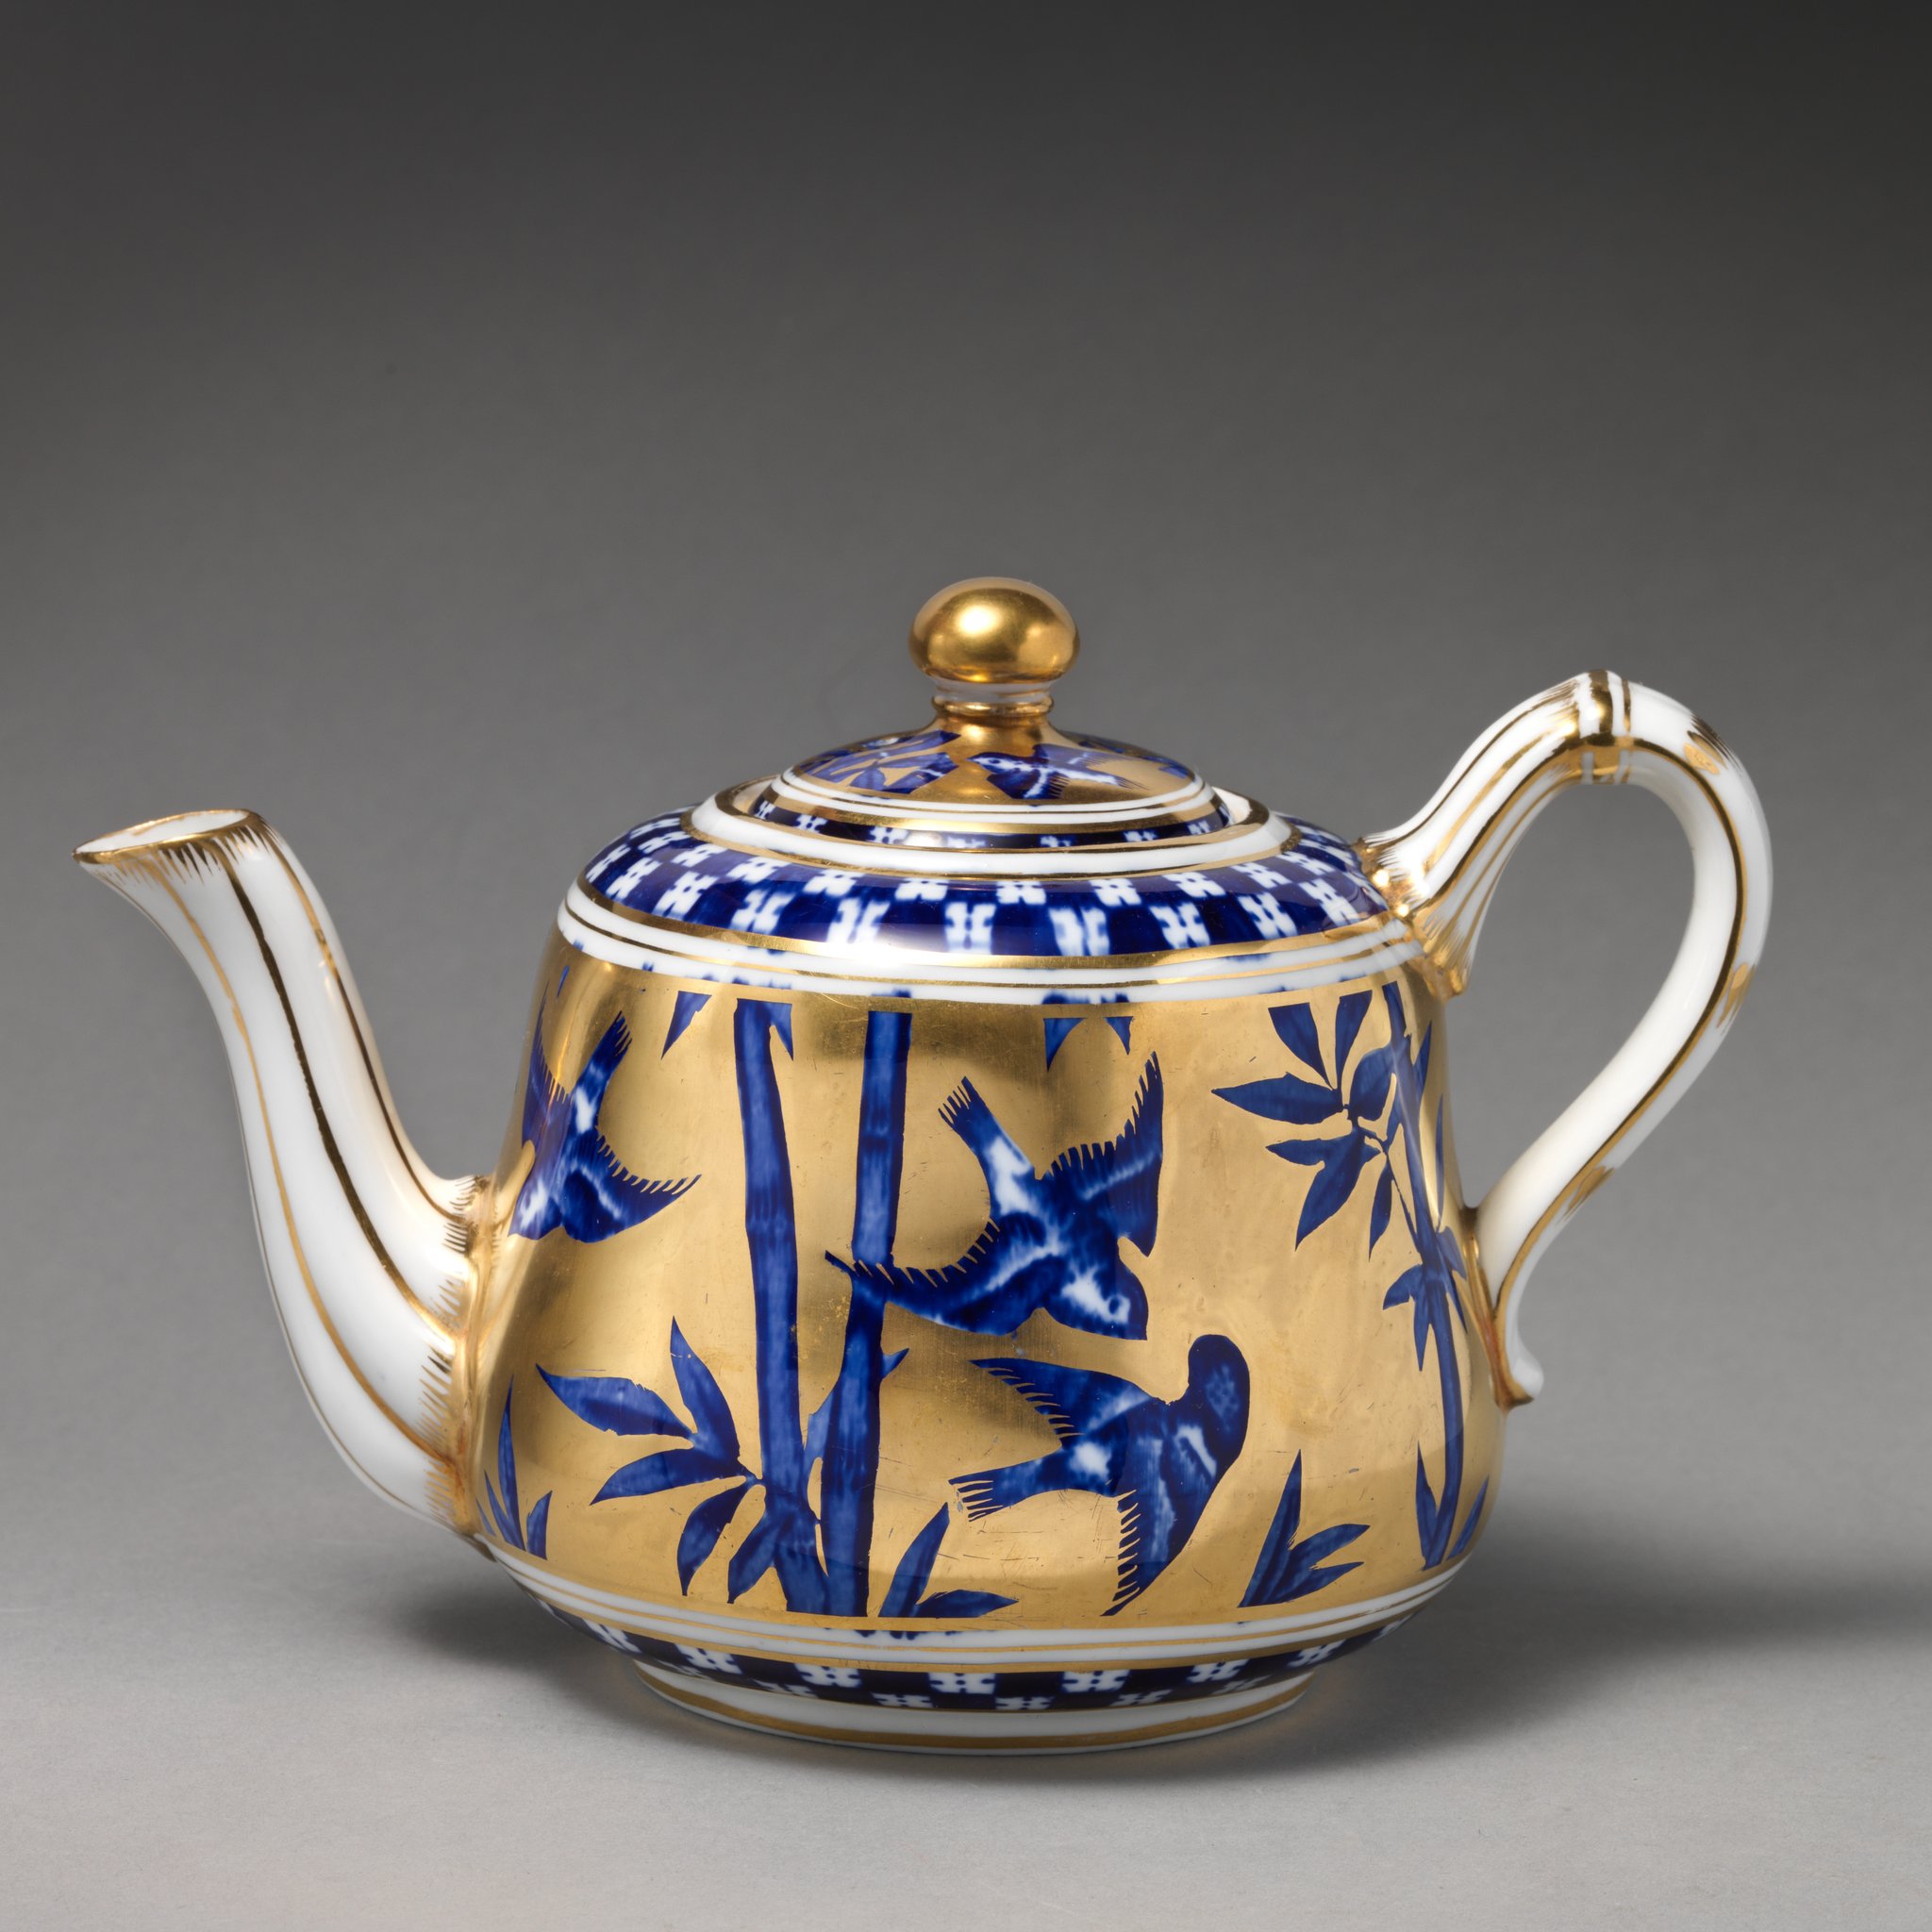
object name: teapot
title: Tea pot (part of a service)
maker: coalport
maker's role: maker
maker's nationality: british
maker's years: 1794-1926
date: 1875-1881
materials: porcelain